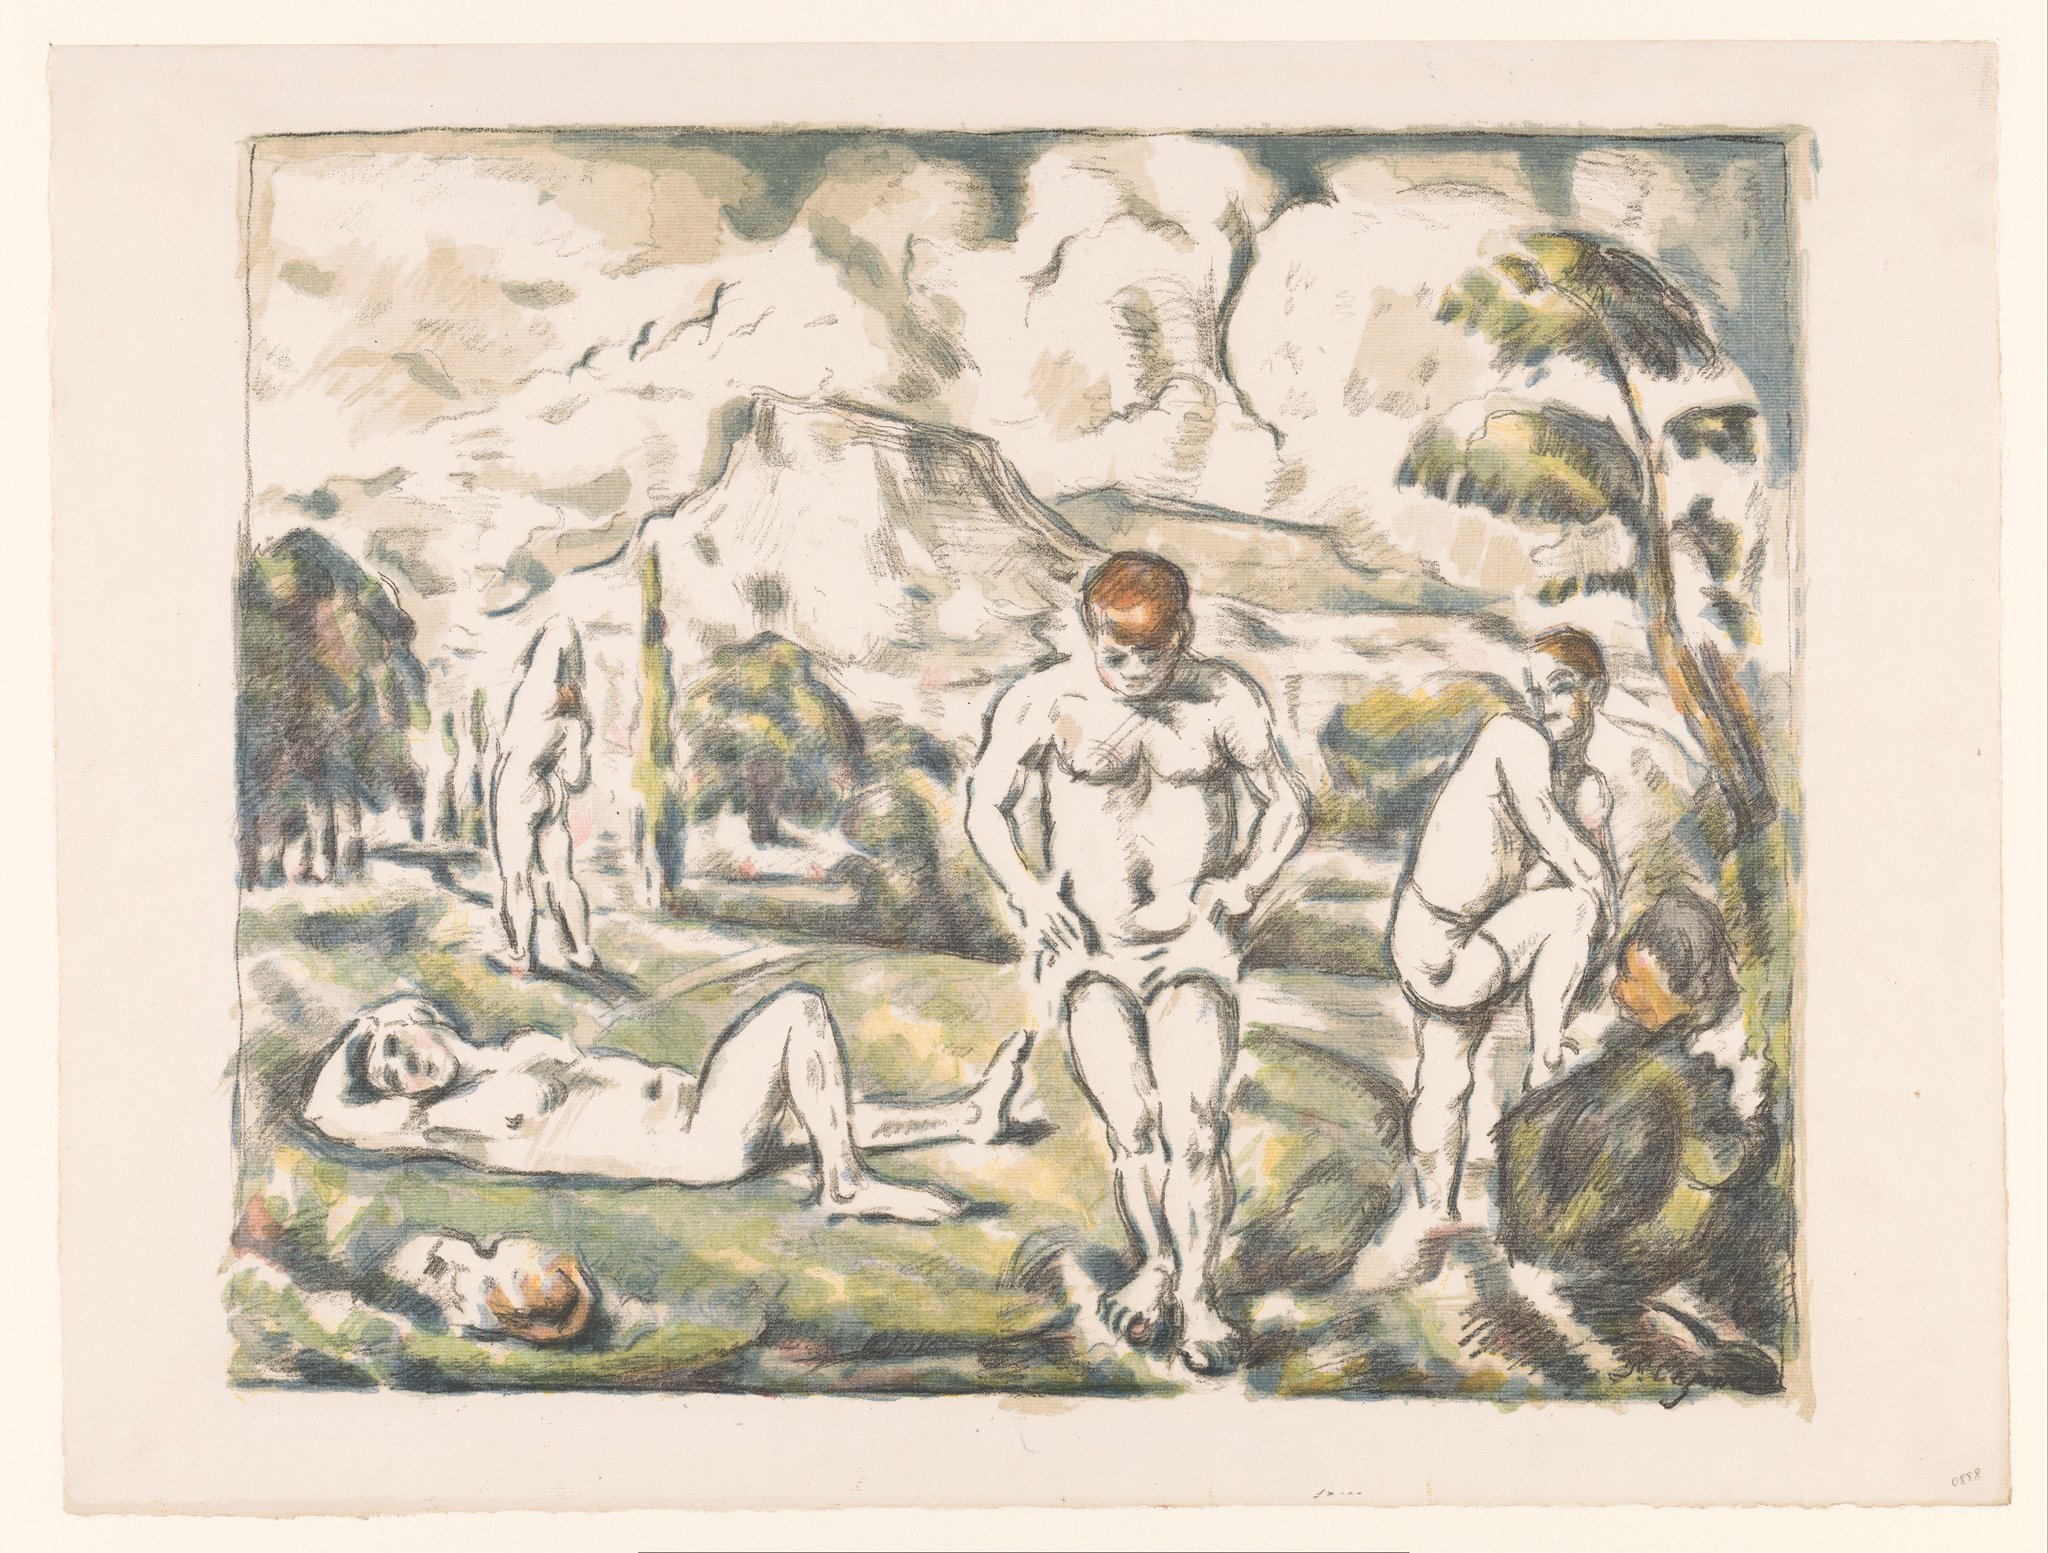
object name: print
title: Les Grands Baigneurs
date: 1896-1898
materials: paper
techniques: lithograph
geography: paris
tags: taking a bath - aa - in the open air, (high) hill (+ landscape with figures, staffage)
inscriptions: collector's mark: Lugt 2228a